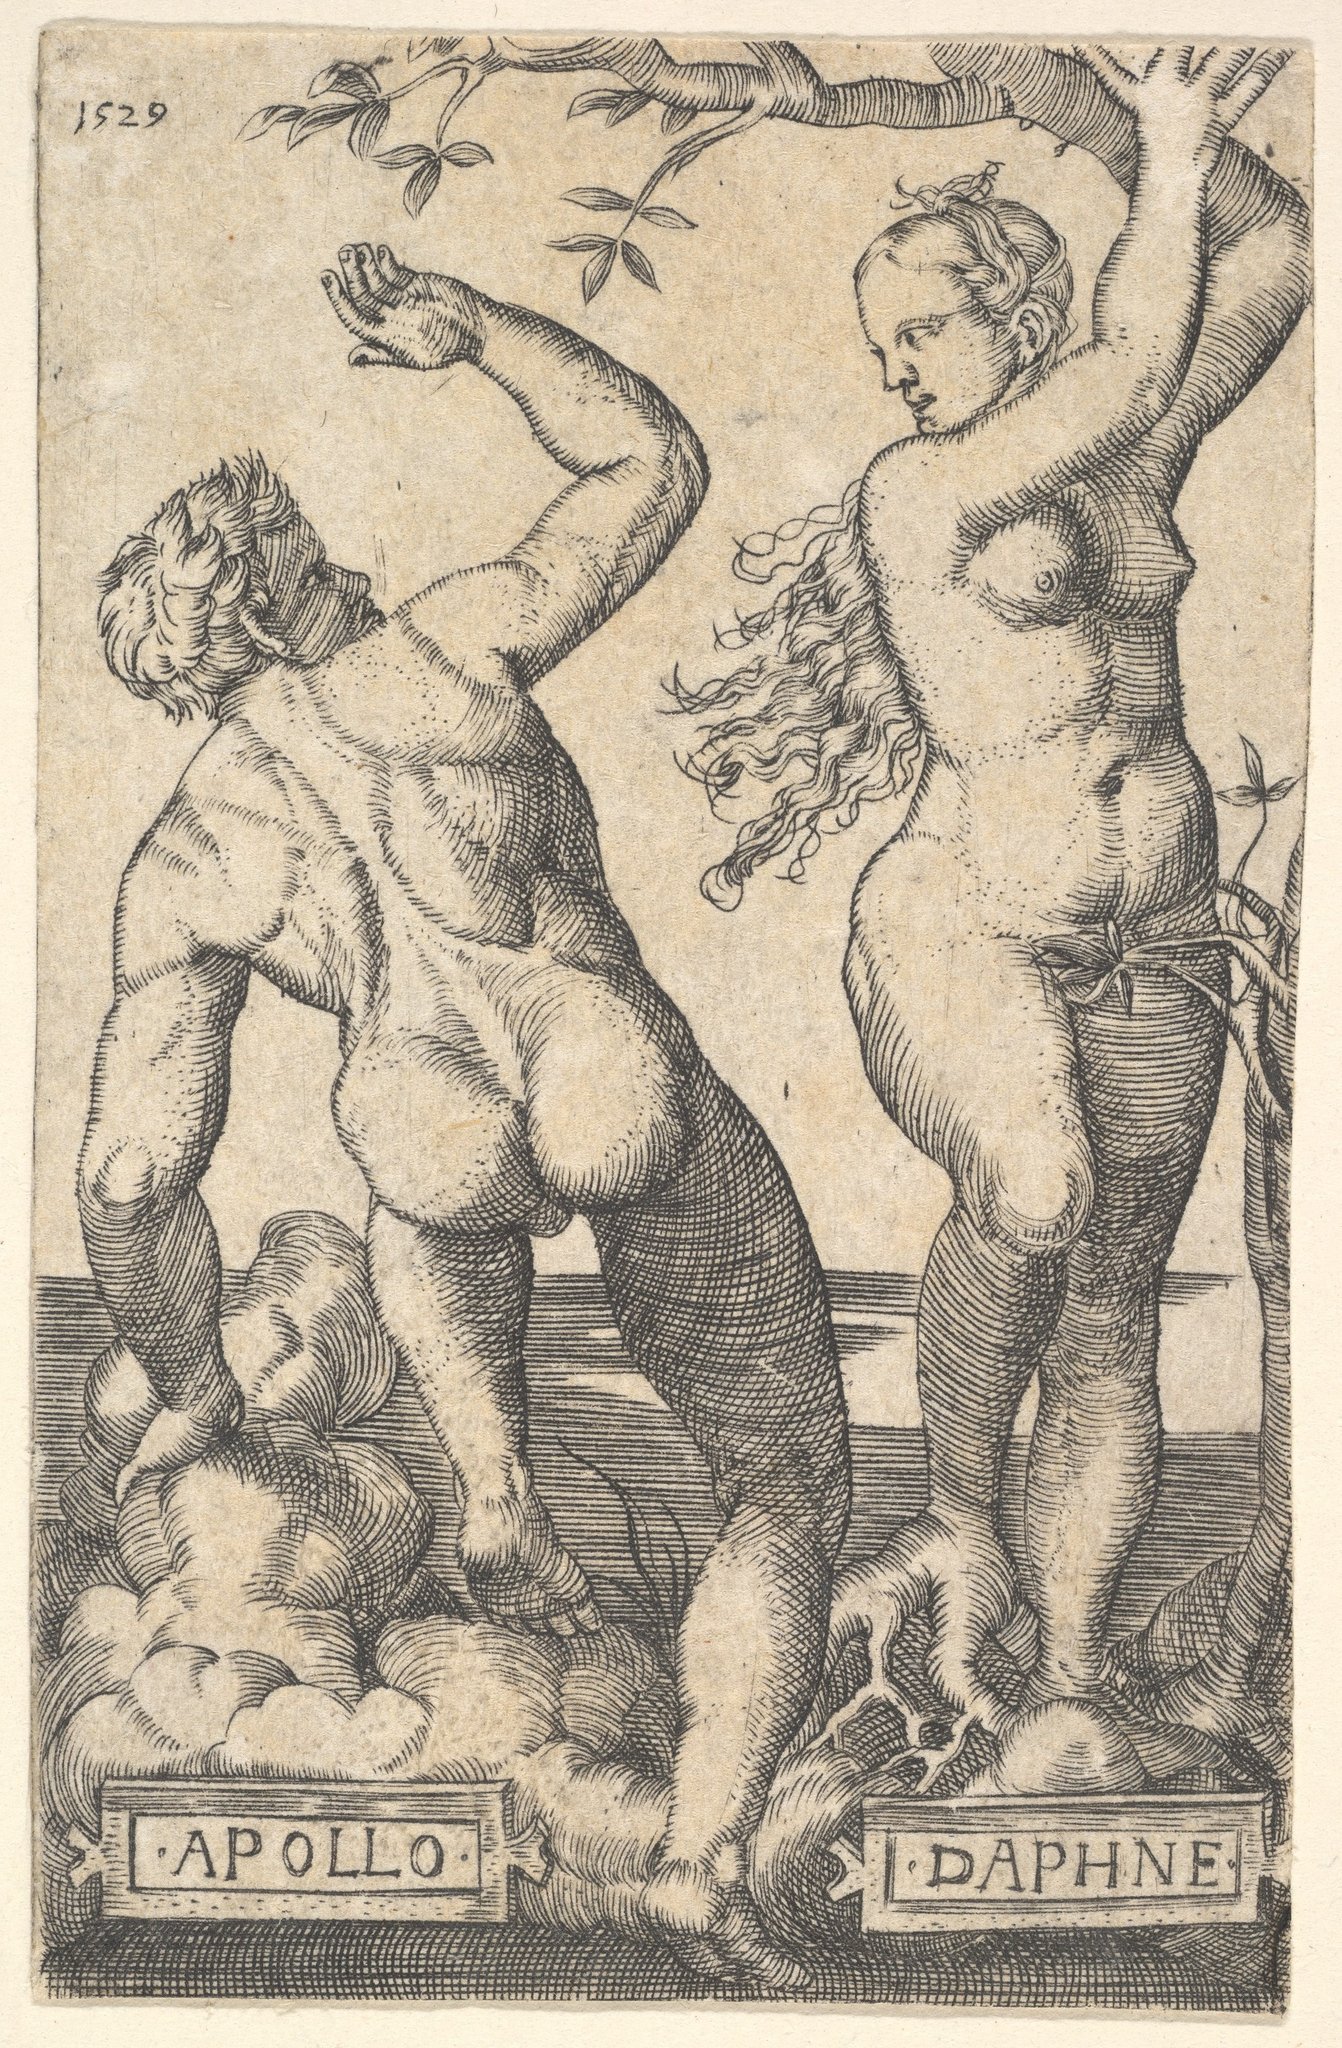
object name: print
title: Apollo and Daphne (reverse copy)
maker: barthel beham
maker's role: artist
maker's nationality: german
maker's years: 1502-1540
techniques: engraving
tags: apollo,nymphs